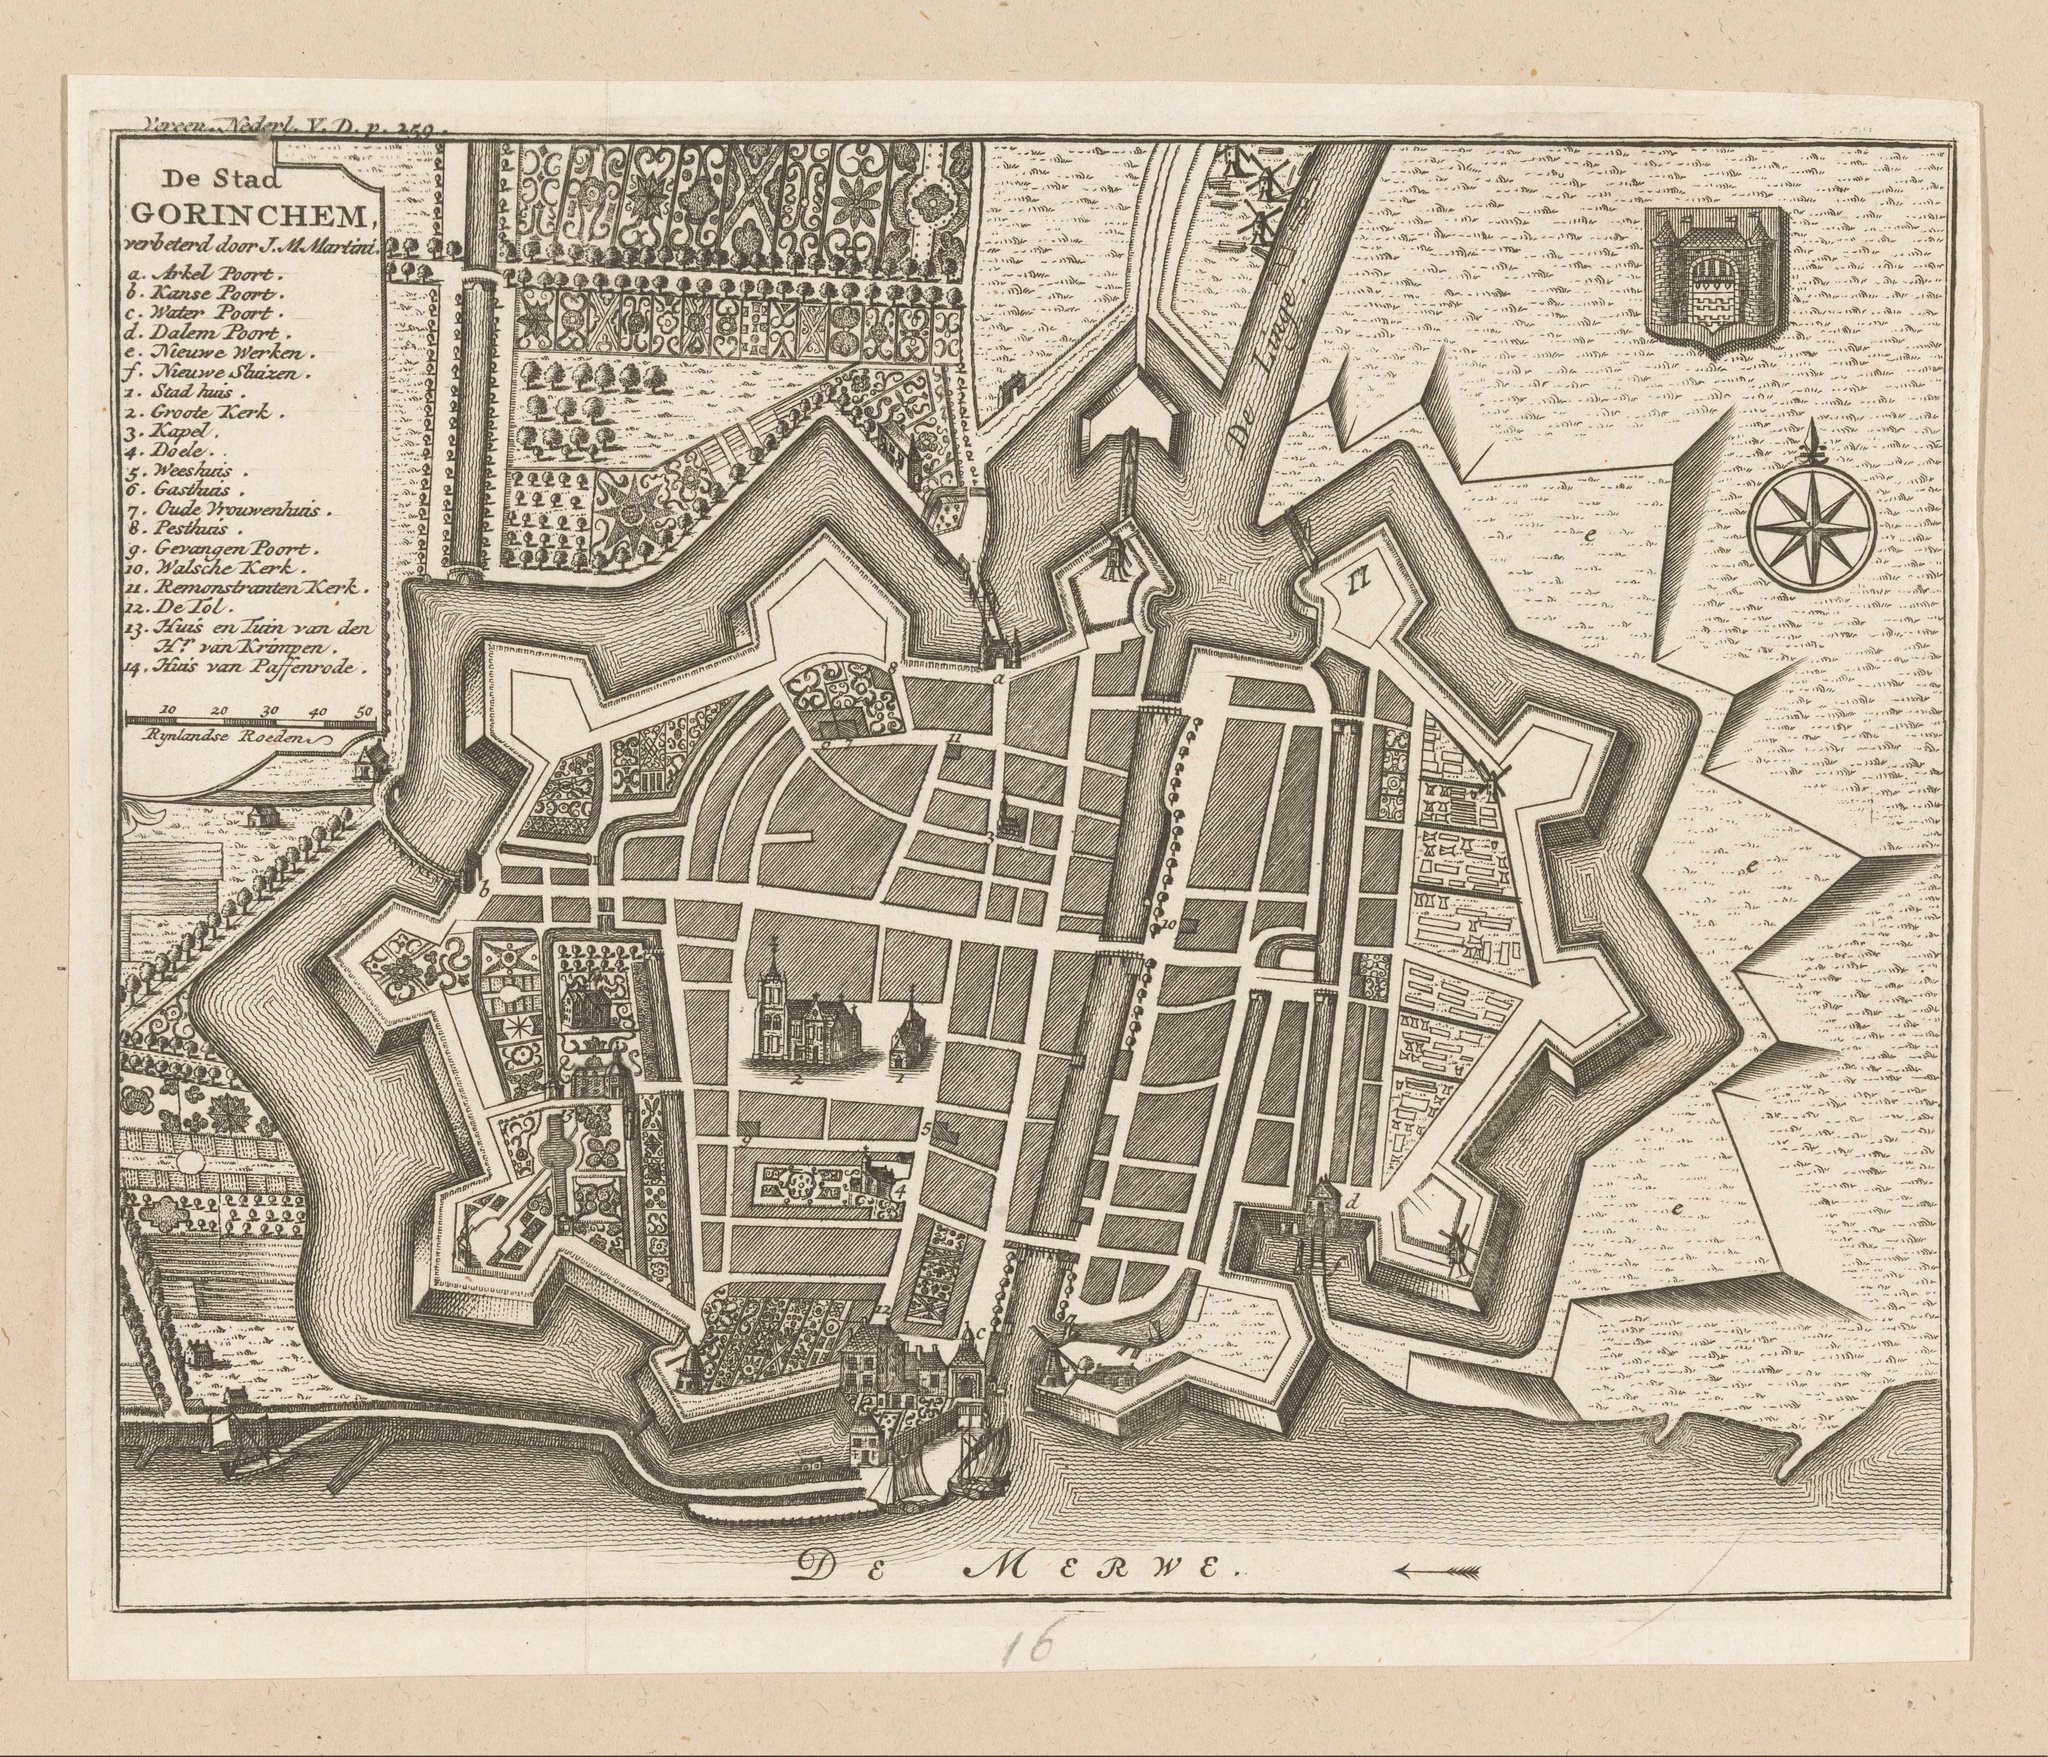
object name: area plan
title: De stad Gorinchem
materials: paper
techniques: engraving, etching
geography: amsterdam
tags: coat of arms (as symbol of the state, etc.) (+ city; municipal), maps of cities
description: Prent ook gebruikt in: Wagenaar, Jan. Tegenwoordige staat der Vereenigde Nederlanden, vyfde deel. Behelzende het vervolg der beschrijvinge van Holland. Met naauwkeurige plans der steden en printverbeeldingen versierd / Hedendaagsche historie, of tegenwoordige staat van alle volkeren; XVde deel (…). Amsterdam: Isaak Tirion, 1744, tussen p. 258 en 259. En in: Beknopte atlas, van omtrent honderd platte gronden der voornaamste vestingen, kasteelen en steden van Europa, en byzonder van de Nederlanden en eenige kolonien (…). Amsterdam: Compagnie van Boekverkopers, s.a. [na 1780].